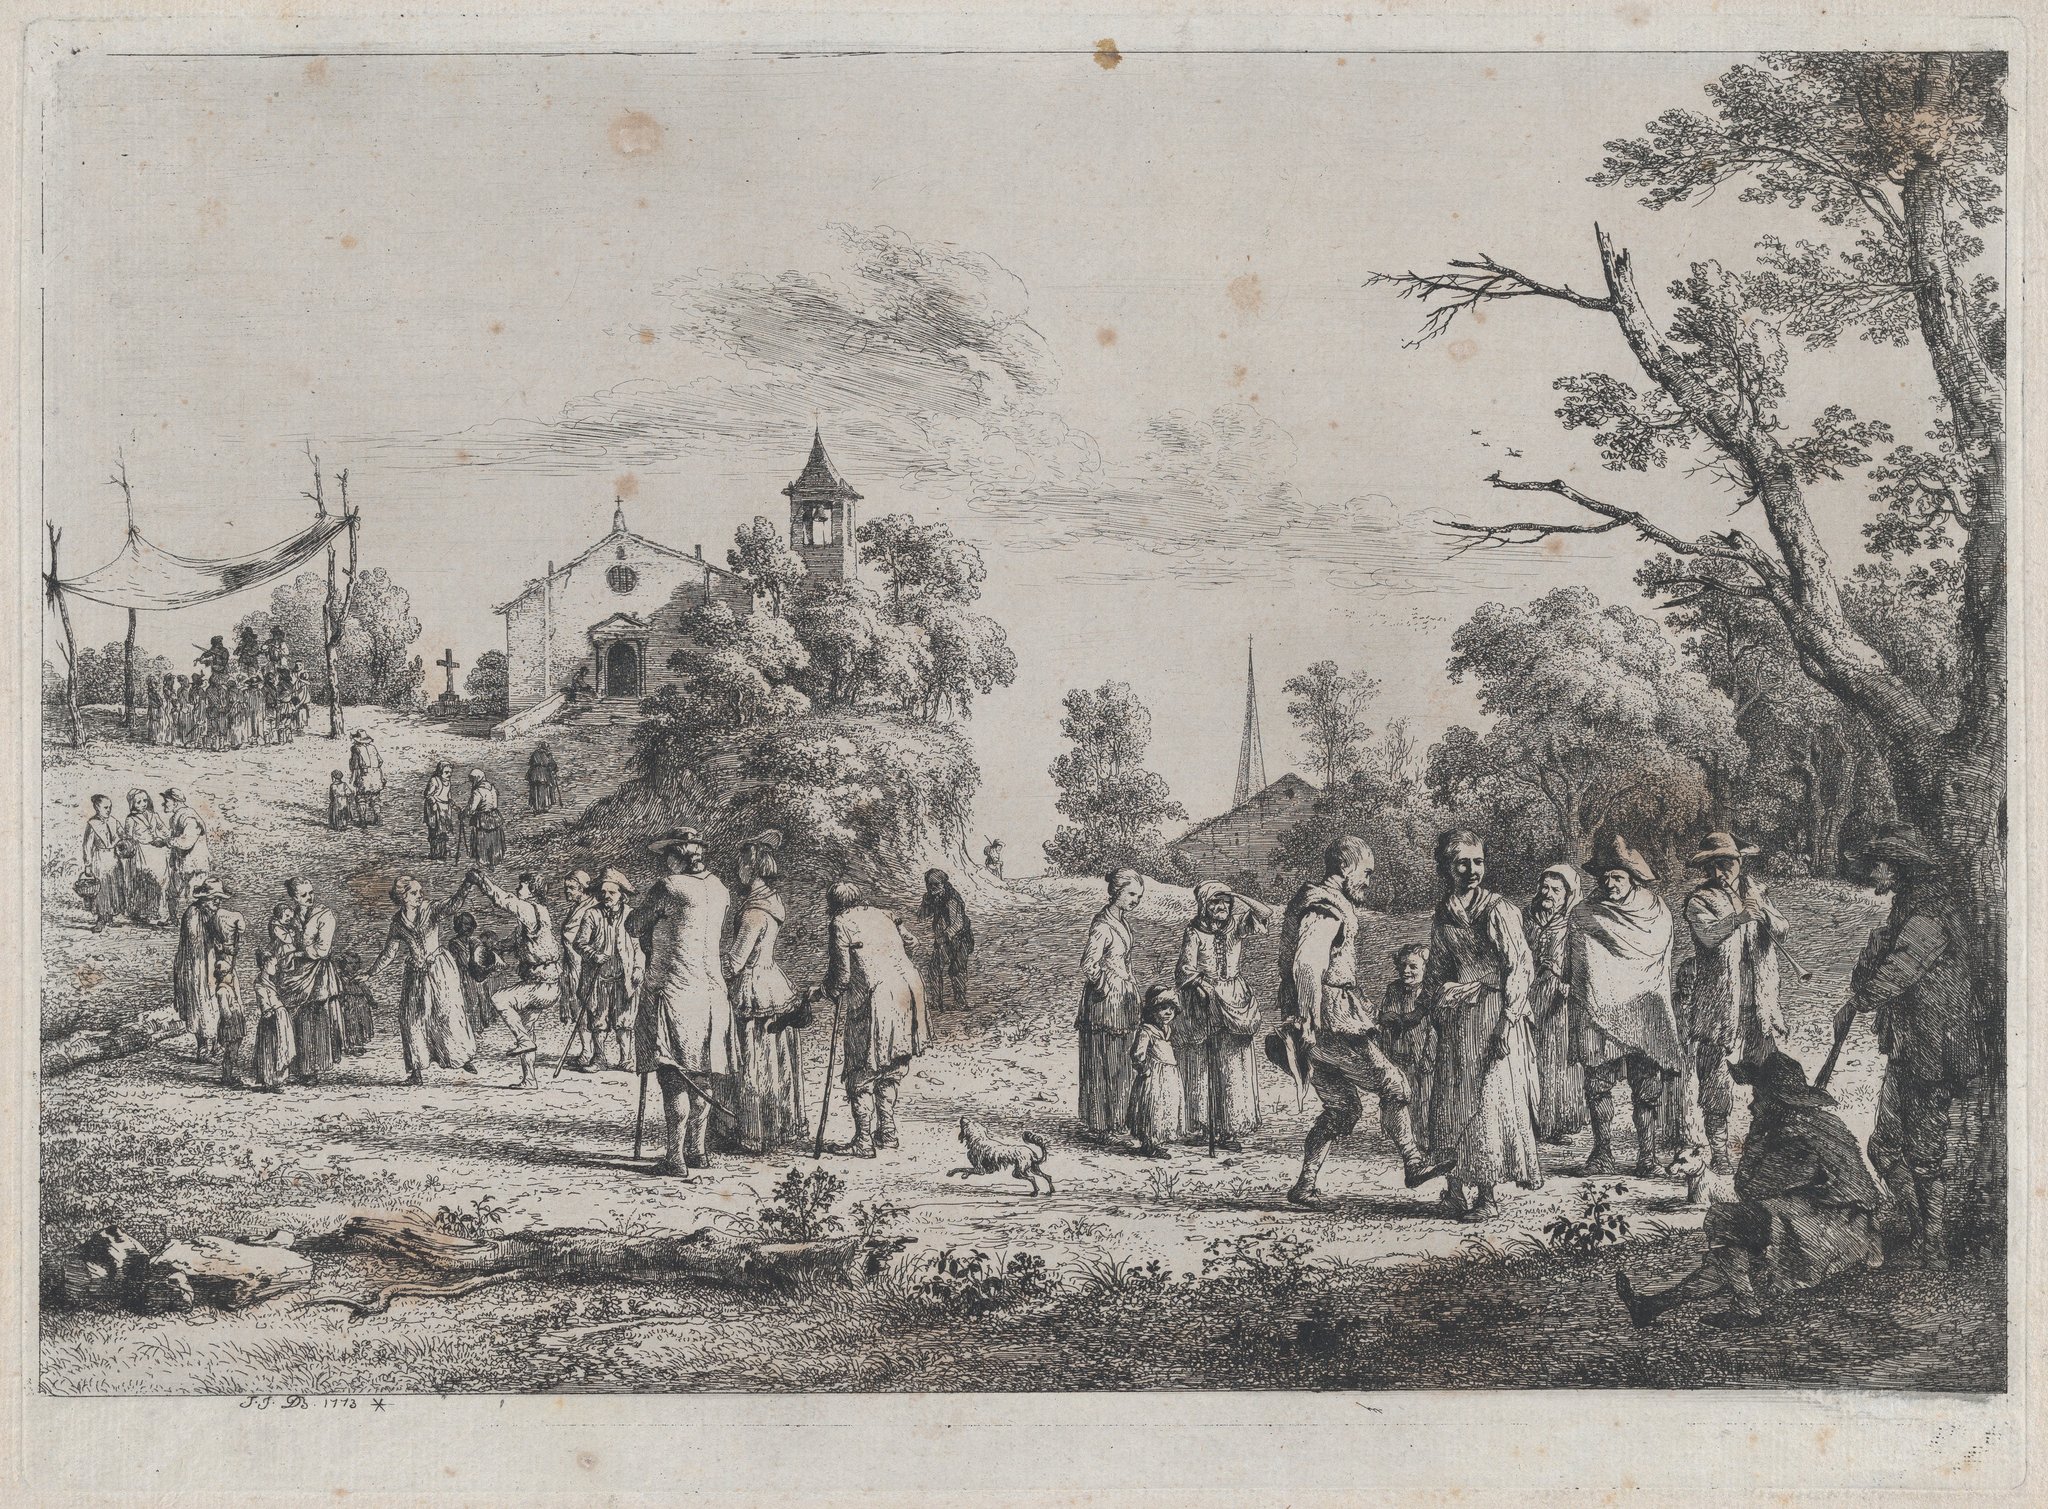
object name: print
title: Village Festival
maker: jean jacques de boissieu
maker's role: artist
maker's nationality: french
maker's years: 1736-1810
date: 1773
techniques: etching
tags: villages,men,women,dancing,dogs